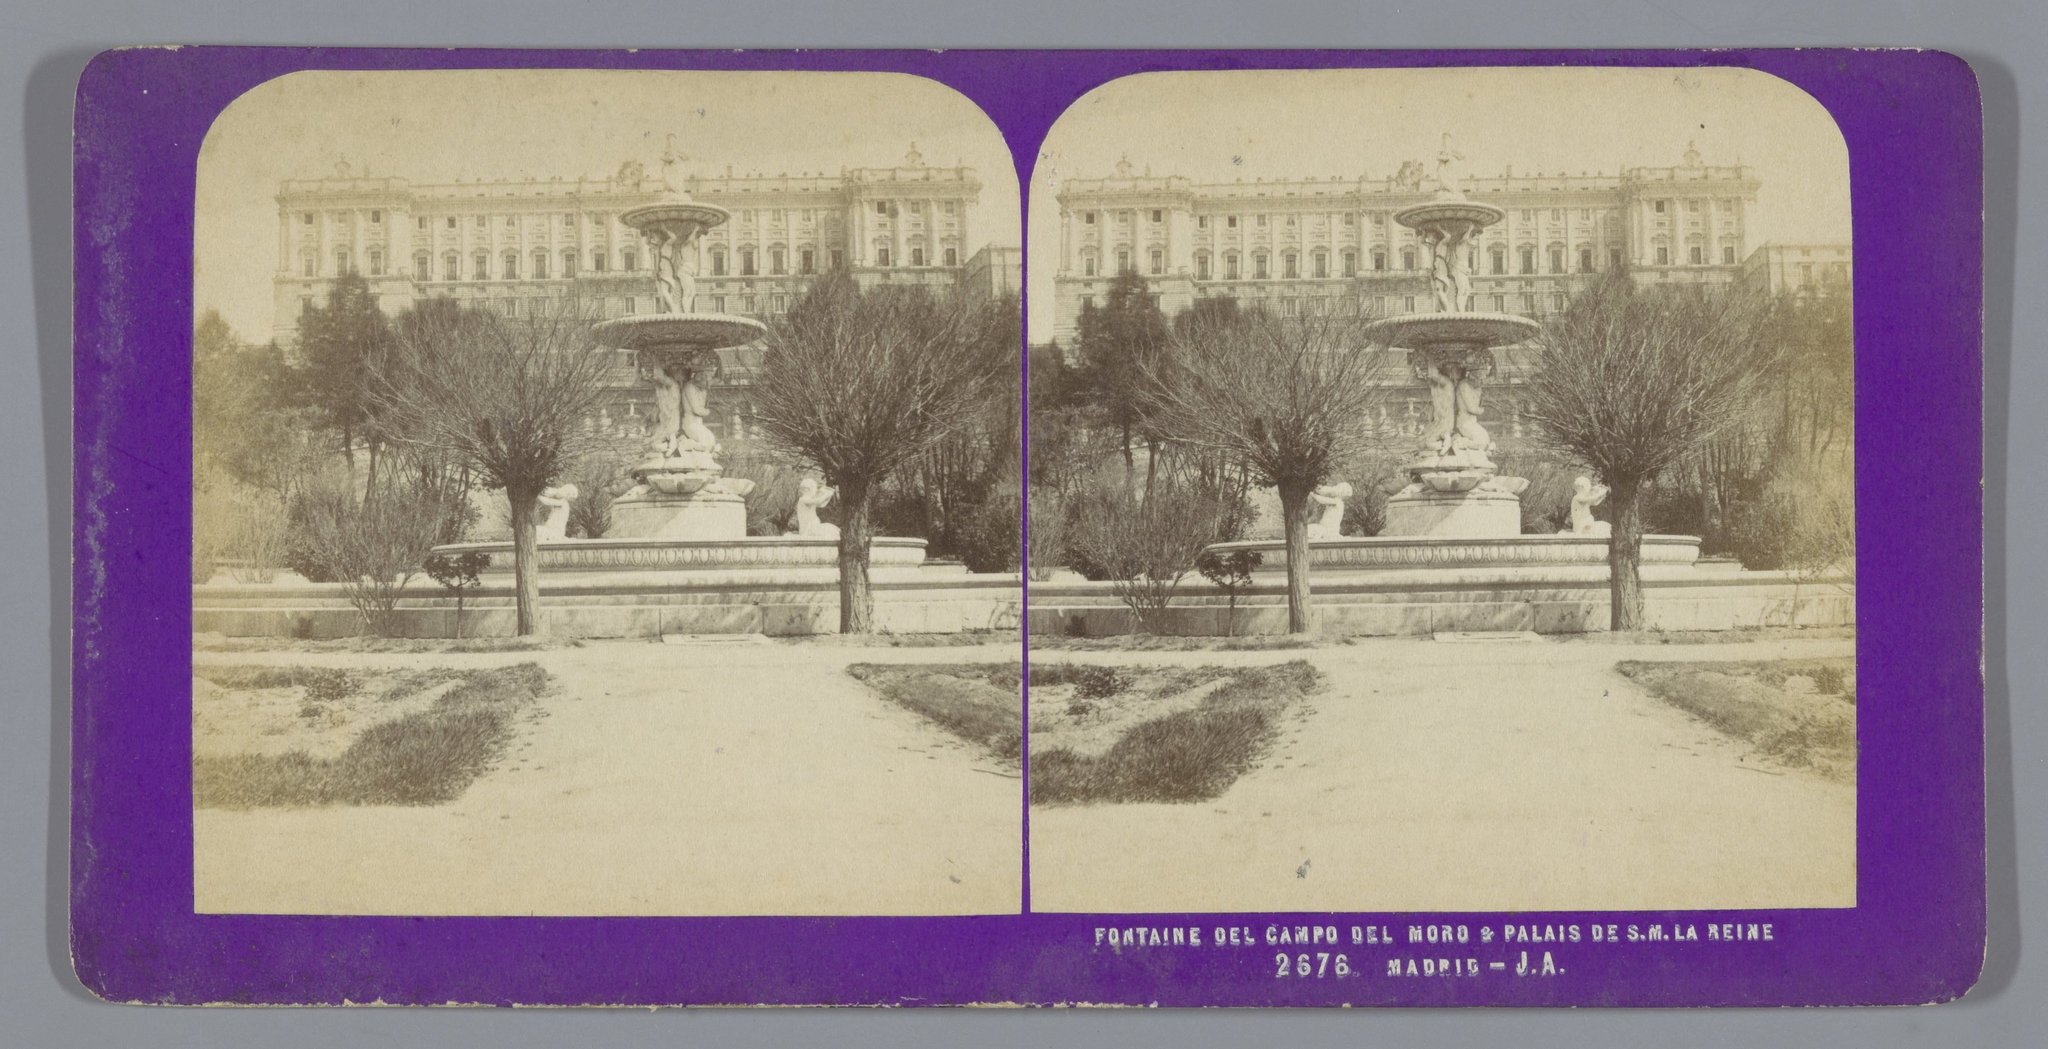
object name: stereograph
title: Fontein te Madrid, met op de achtergrond het Palacio Real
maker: jean andrieu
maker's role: fotograaf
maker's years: 1816-1872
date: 1862-1876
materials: cardboard, photographic support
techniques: albumen print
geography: madrid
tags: palace, ornamental fountain, façade (of house or building)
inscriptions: number: ‘2676.’